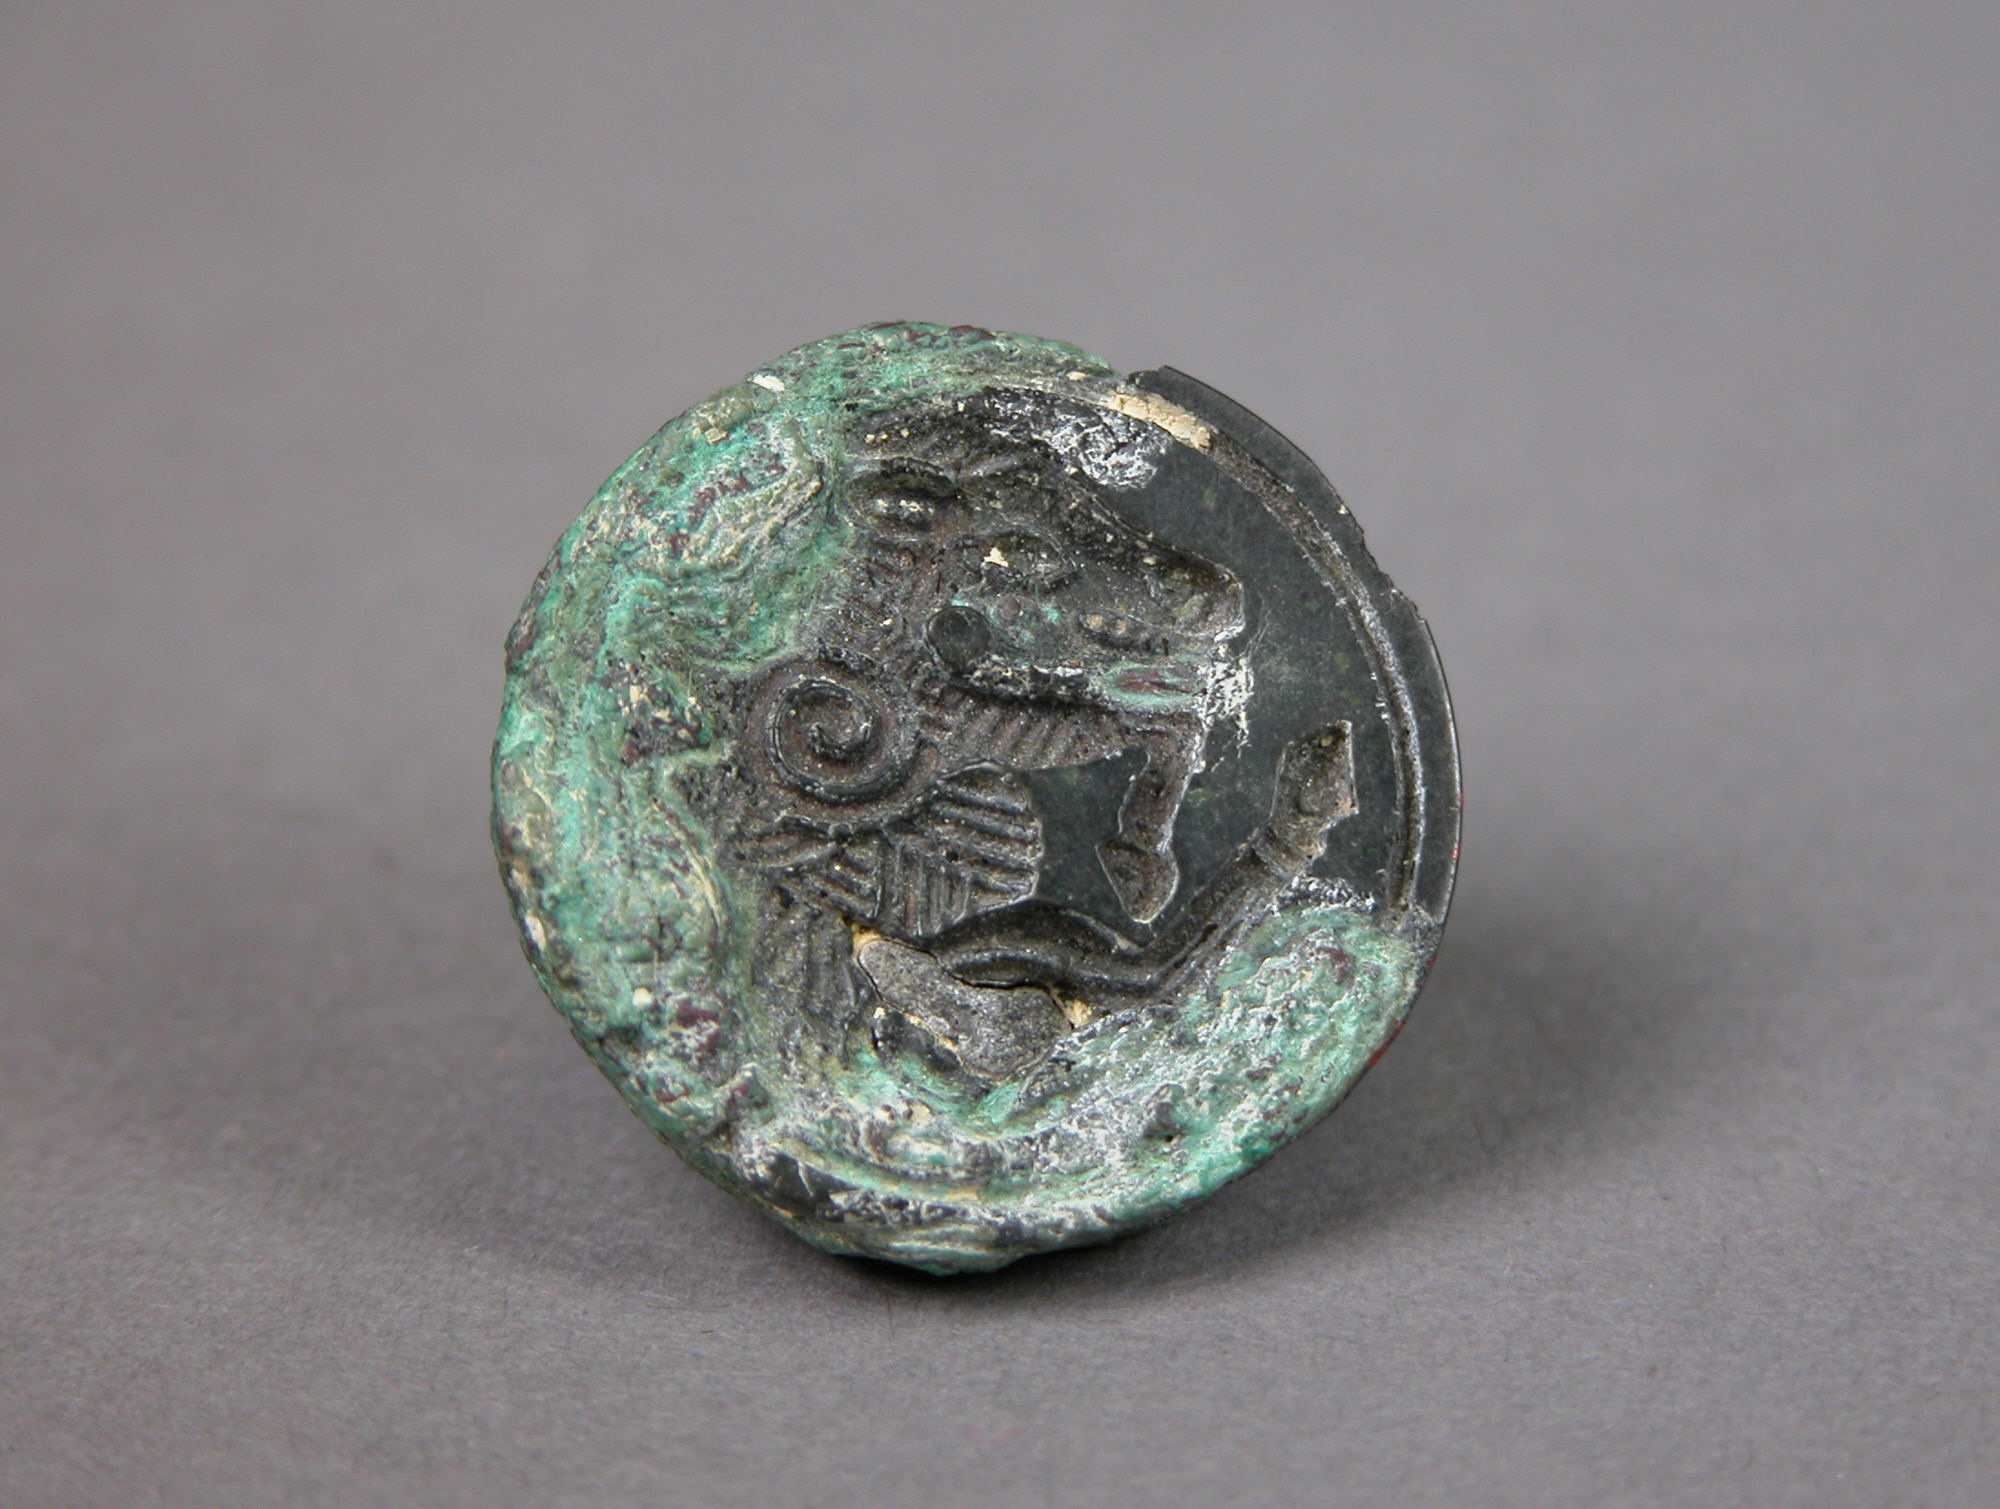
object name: seal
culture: chinese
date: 600-501 BCE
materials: bronze